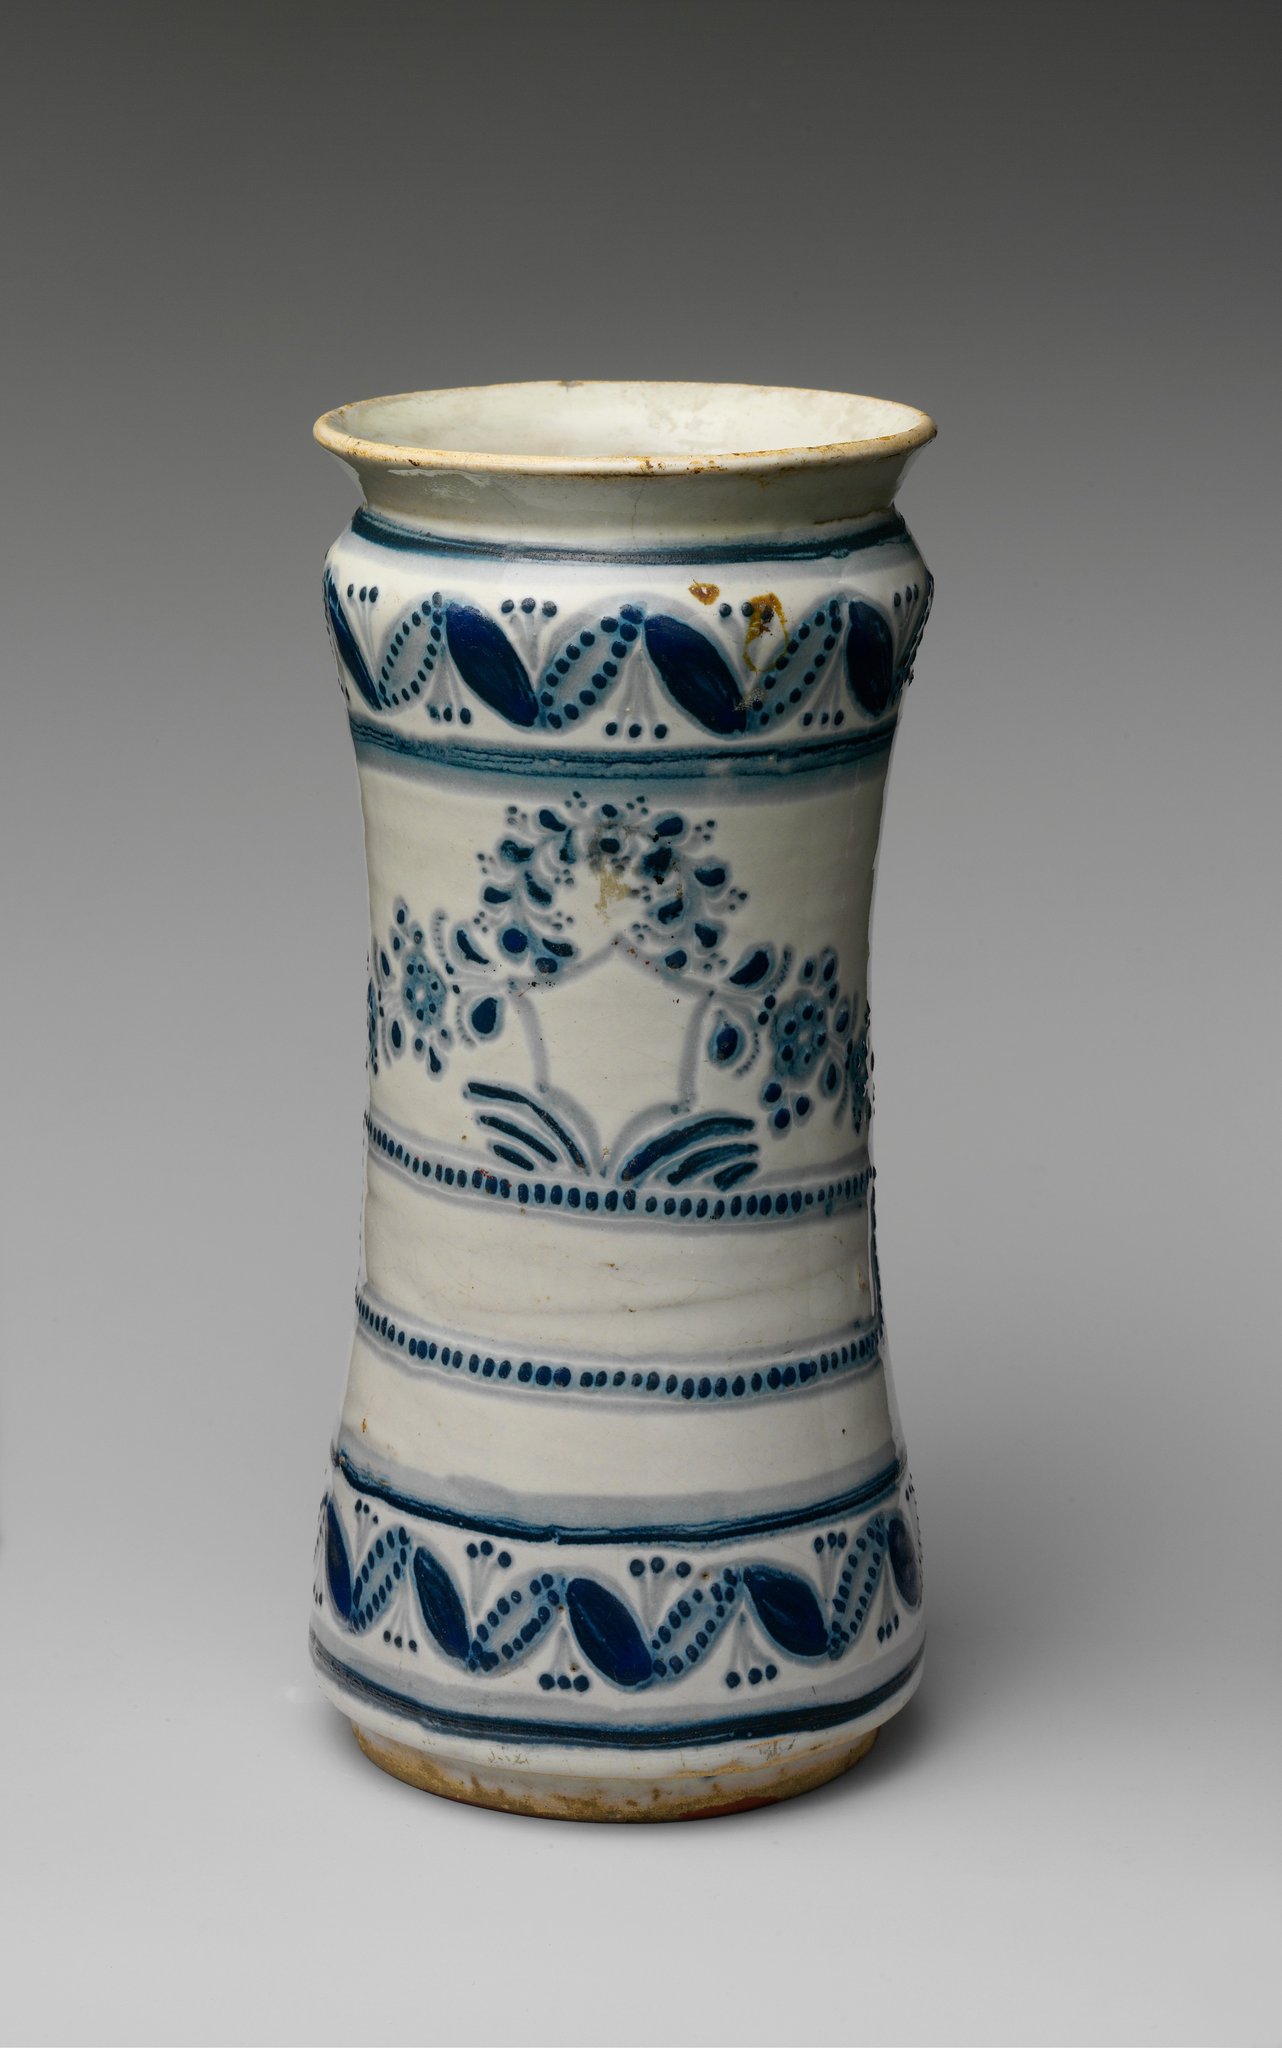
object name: apothecary jar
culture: mexican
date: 1750-1800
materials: earthenware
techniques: glazing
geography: mexico